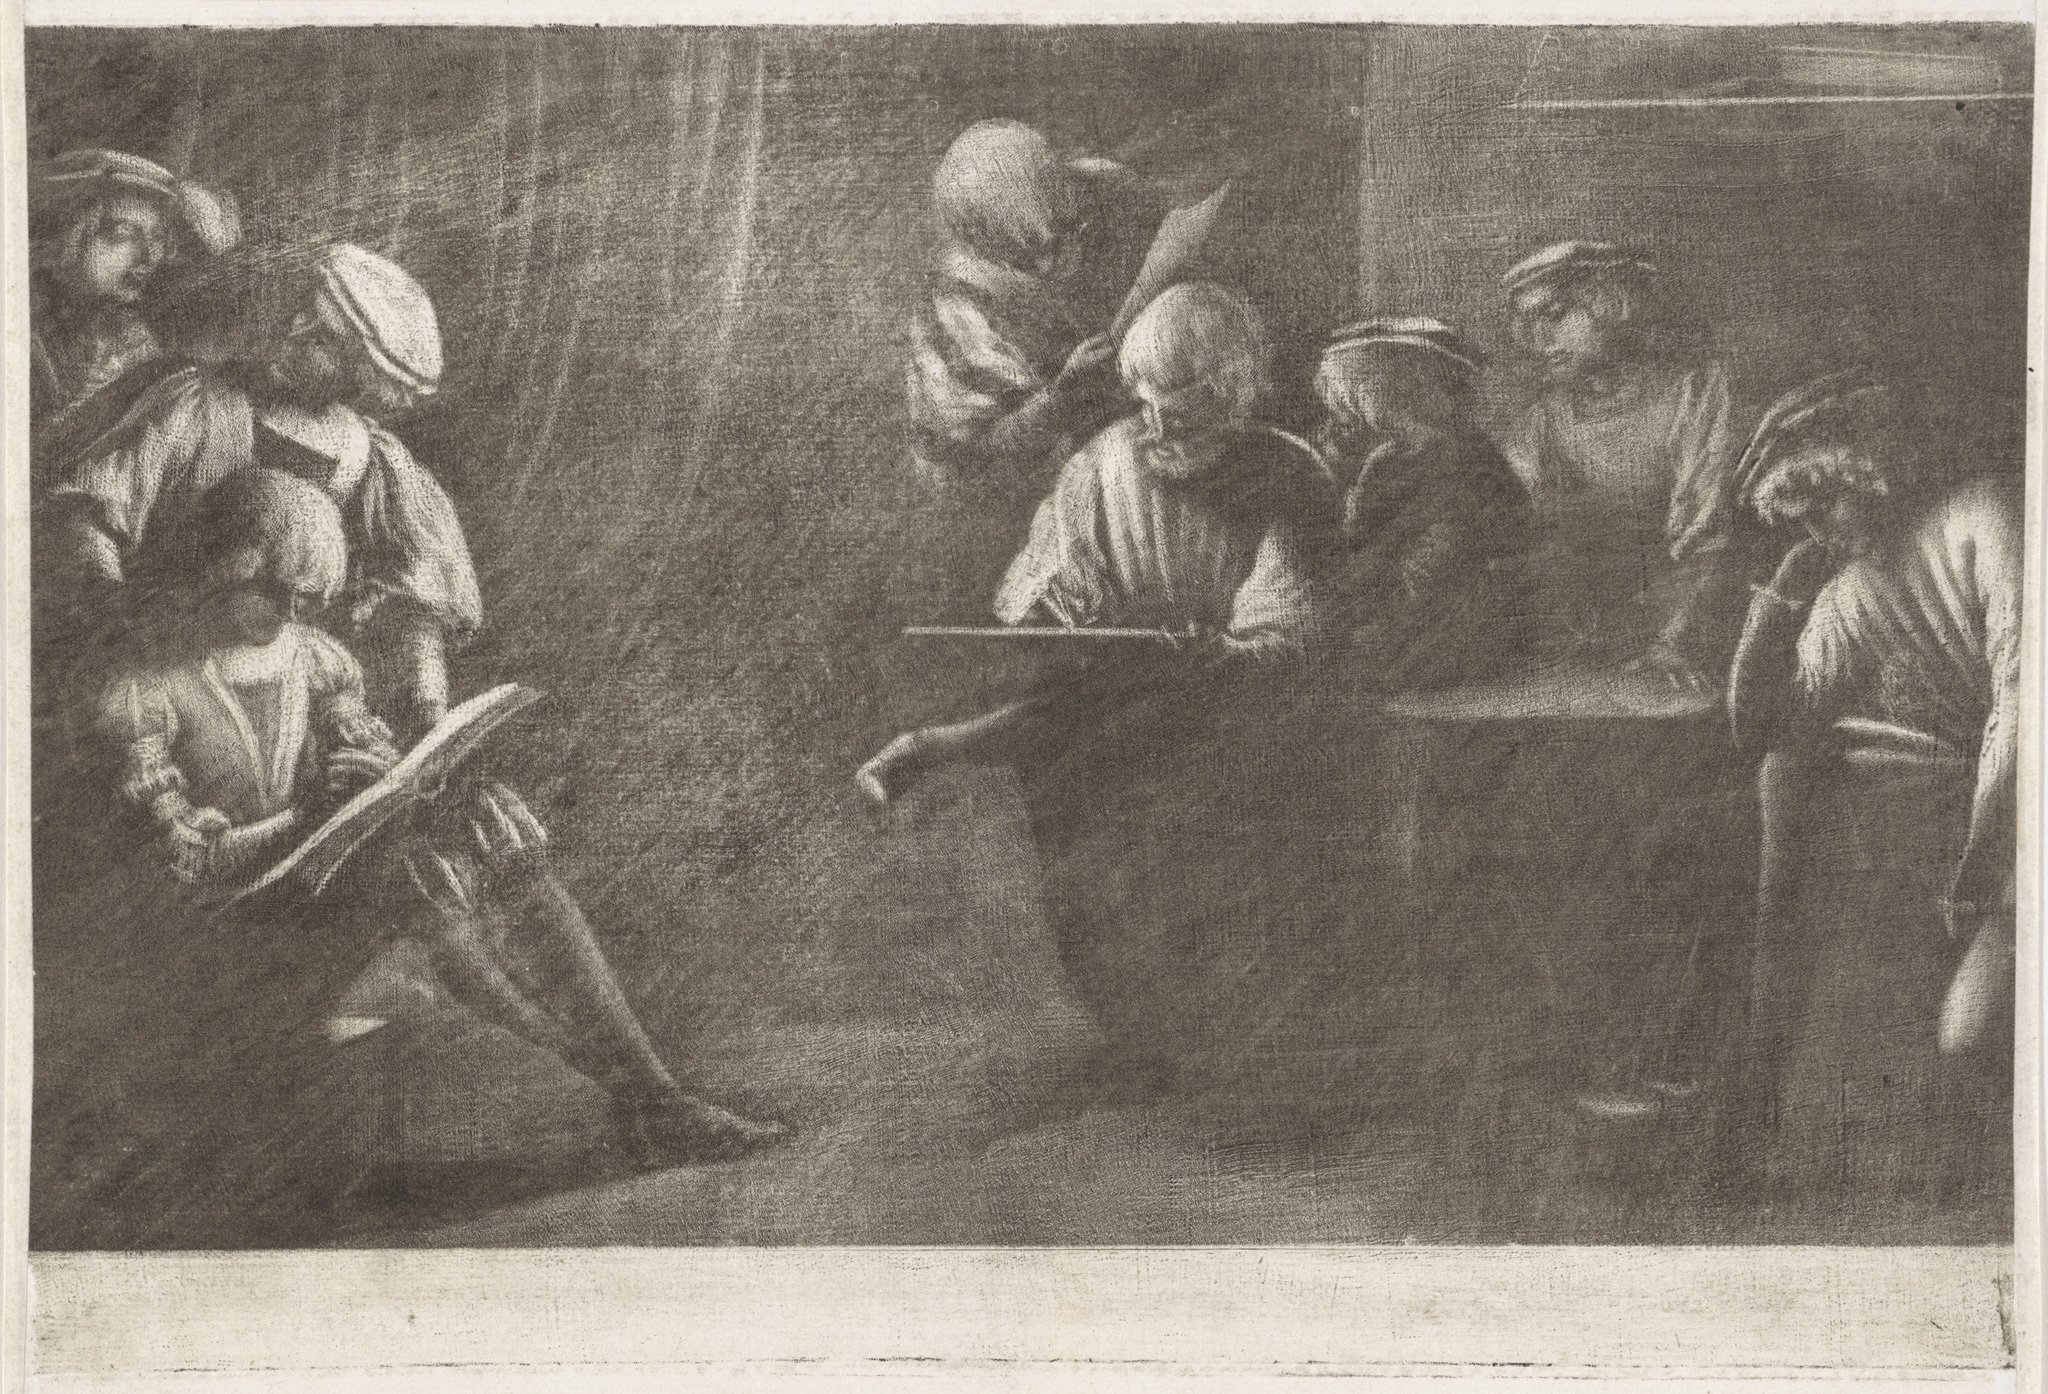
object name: print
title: Tekenschool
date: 1650-1727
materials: paper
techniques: mezzotint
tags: drawing-lesson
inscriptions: collector's mark: Lugt 2228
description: In een vertrek zit een groep mannen te tekenen.